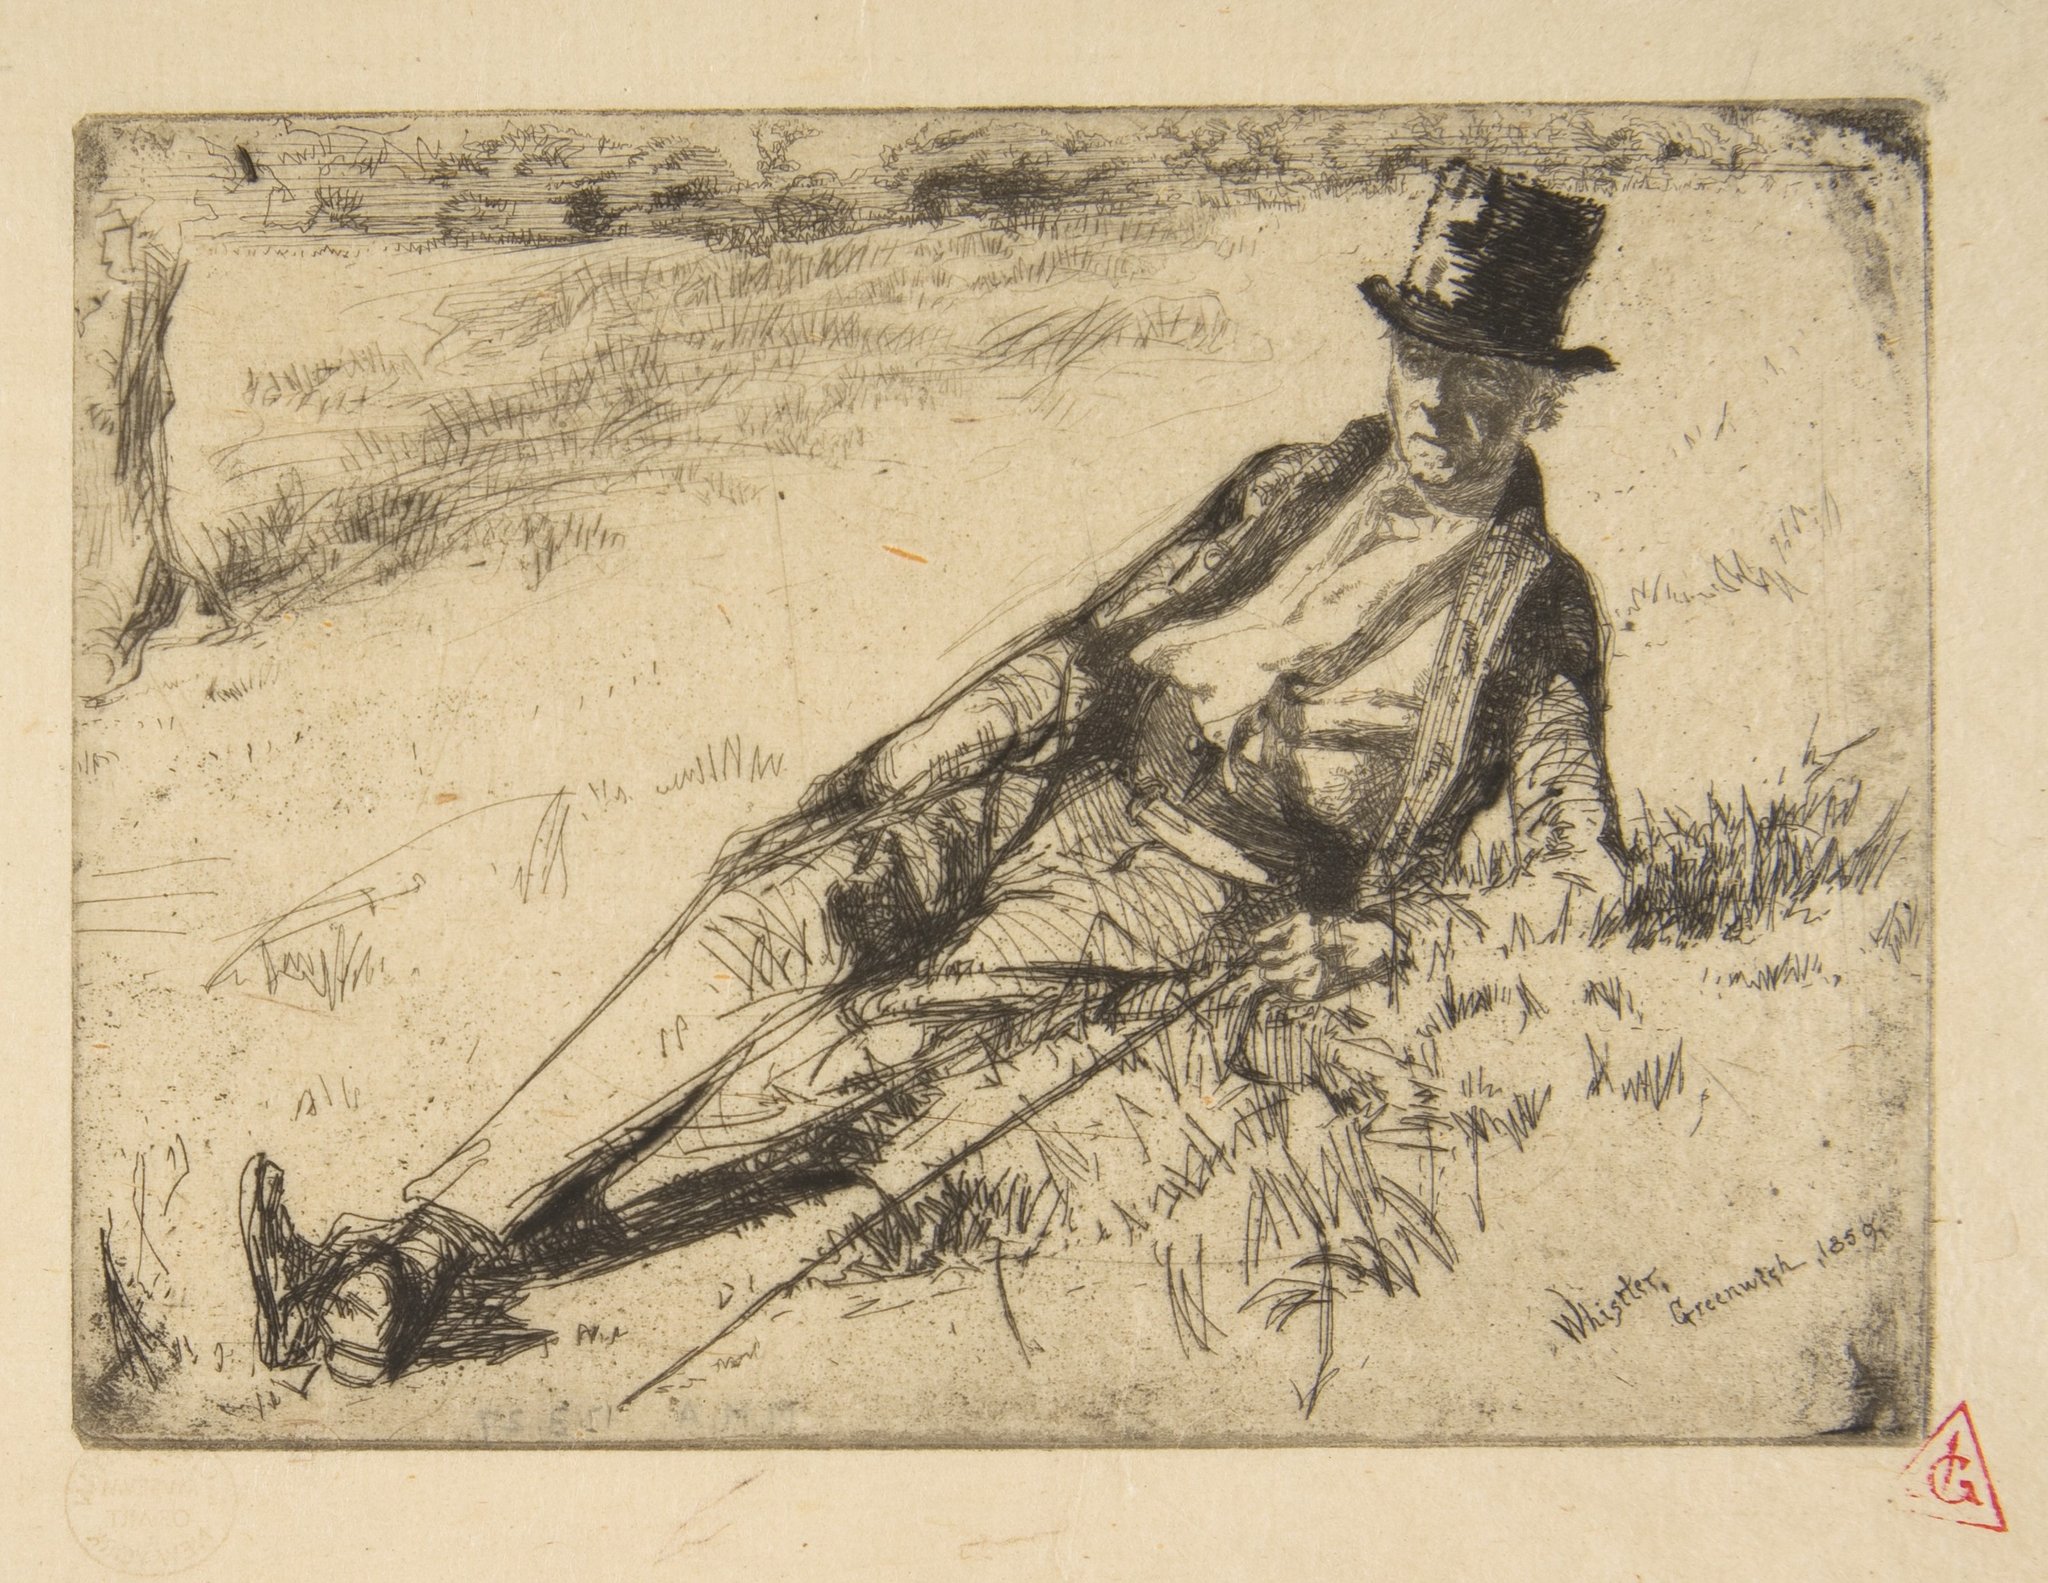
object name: print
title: Greenwich Pensioner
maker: james mcneill whistler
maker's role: artist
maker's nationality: american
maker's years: 1834-1903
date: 1859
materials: ink, ivory, paper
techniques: etching, printing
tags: men